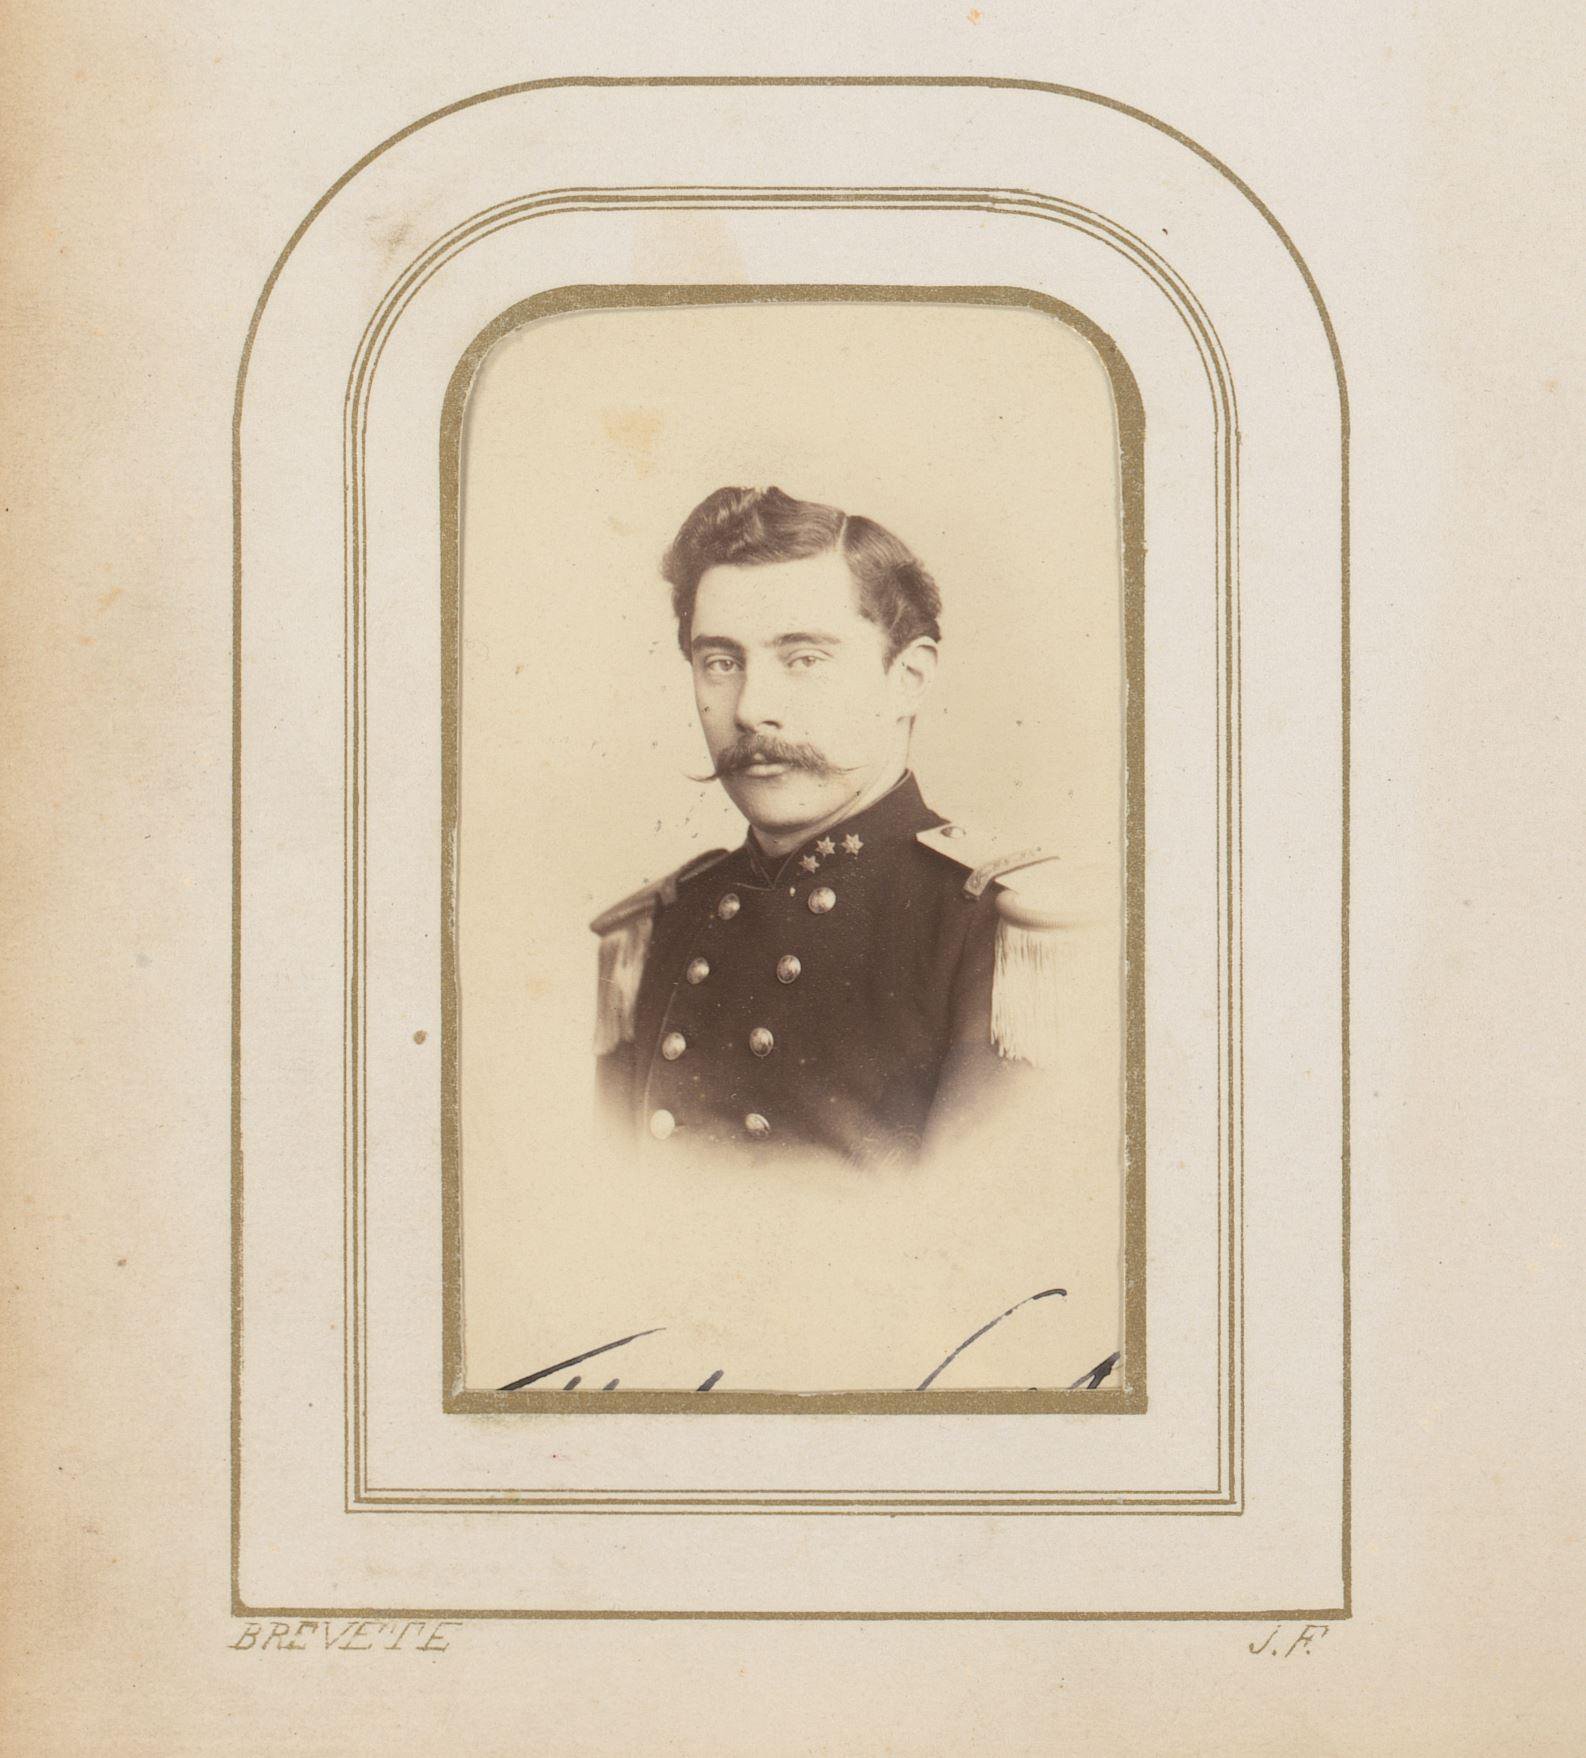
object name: album leaf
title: Portret van een man met snor in uniform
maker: joseph dupont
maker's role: fotograaf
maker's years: 1818-1901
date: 1853-1880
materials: cardboard, photographic support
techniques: albumen print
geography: antwerp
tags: moustache, historical persons, (military) uniforms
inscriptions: annotation: ‘[...]’, inscription: ‘J. Dupont/ Photographe du Roi/ Place de Meir, 23/ Anvers/ Maison fondée en 1853’